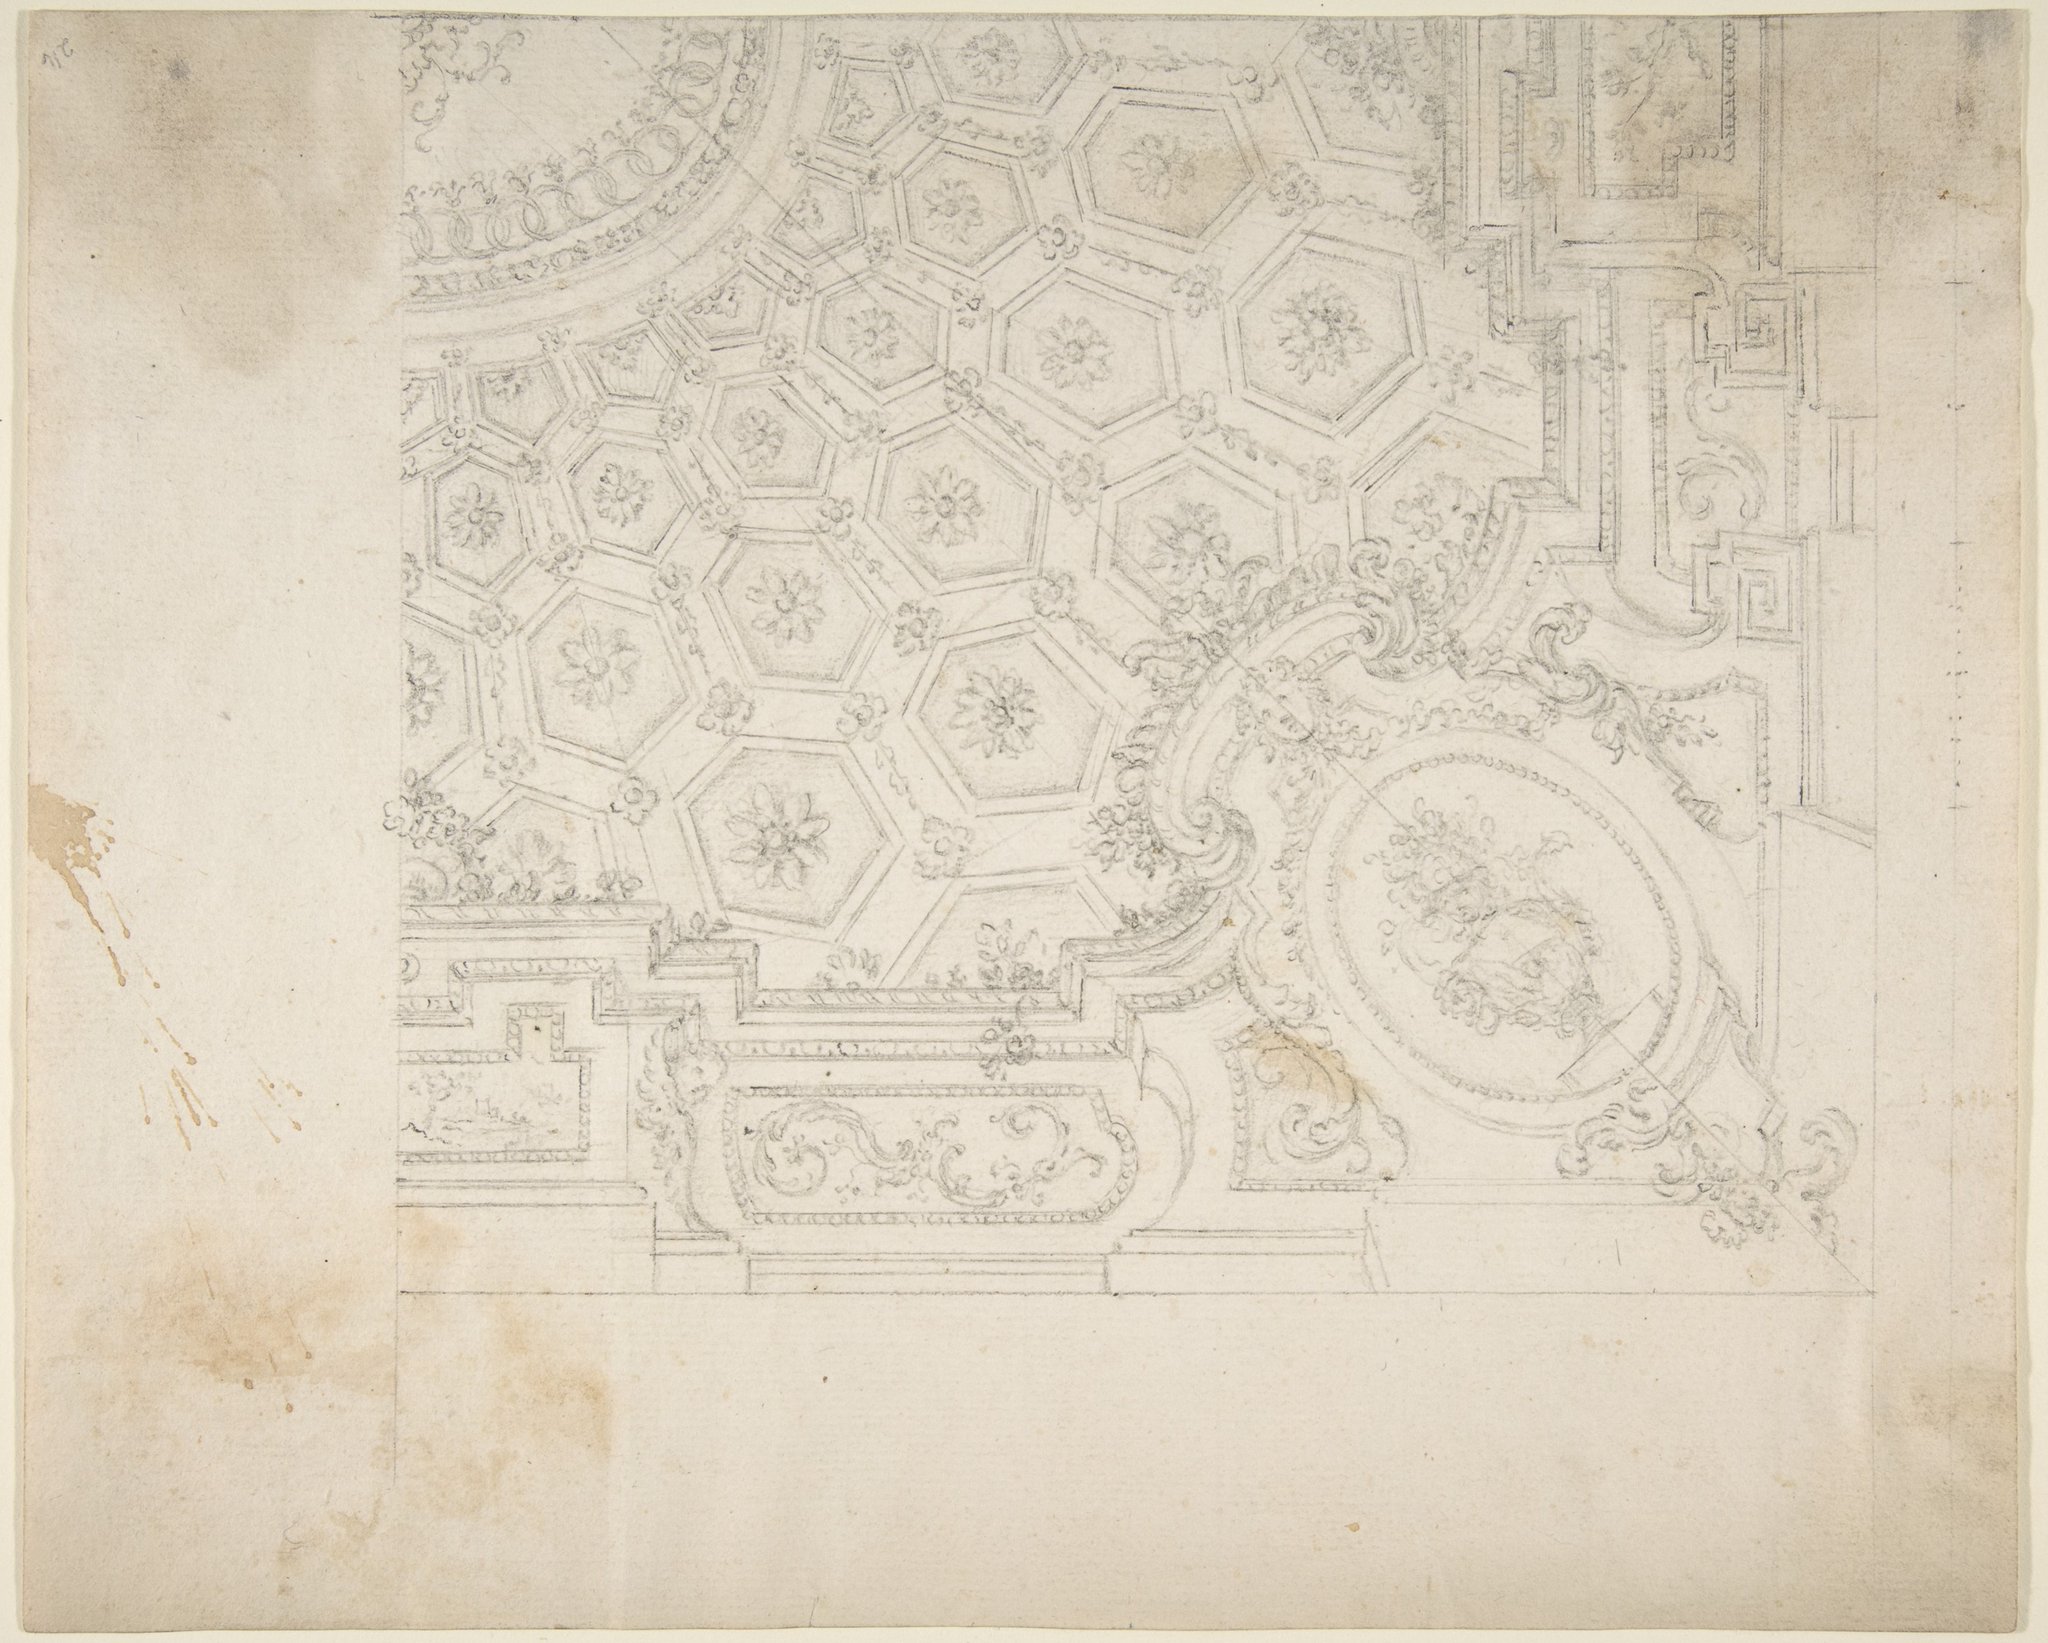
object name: drawing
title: Ceiling Design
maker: leonardo marini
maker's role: artist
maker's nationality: italian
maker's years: 1730-1797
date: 1701-1800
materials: graphite, drawing material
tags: flowers